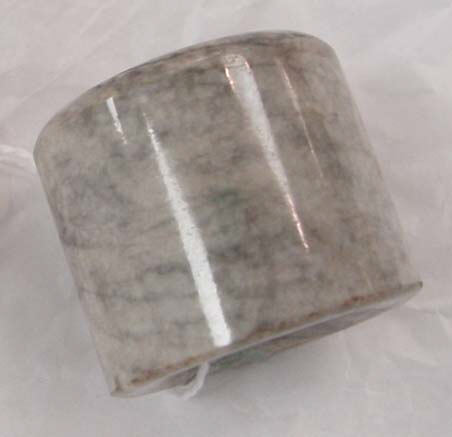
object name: ring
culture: chinese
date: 1801-1900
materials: stone